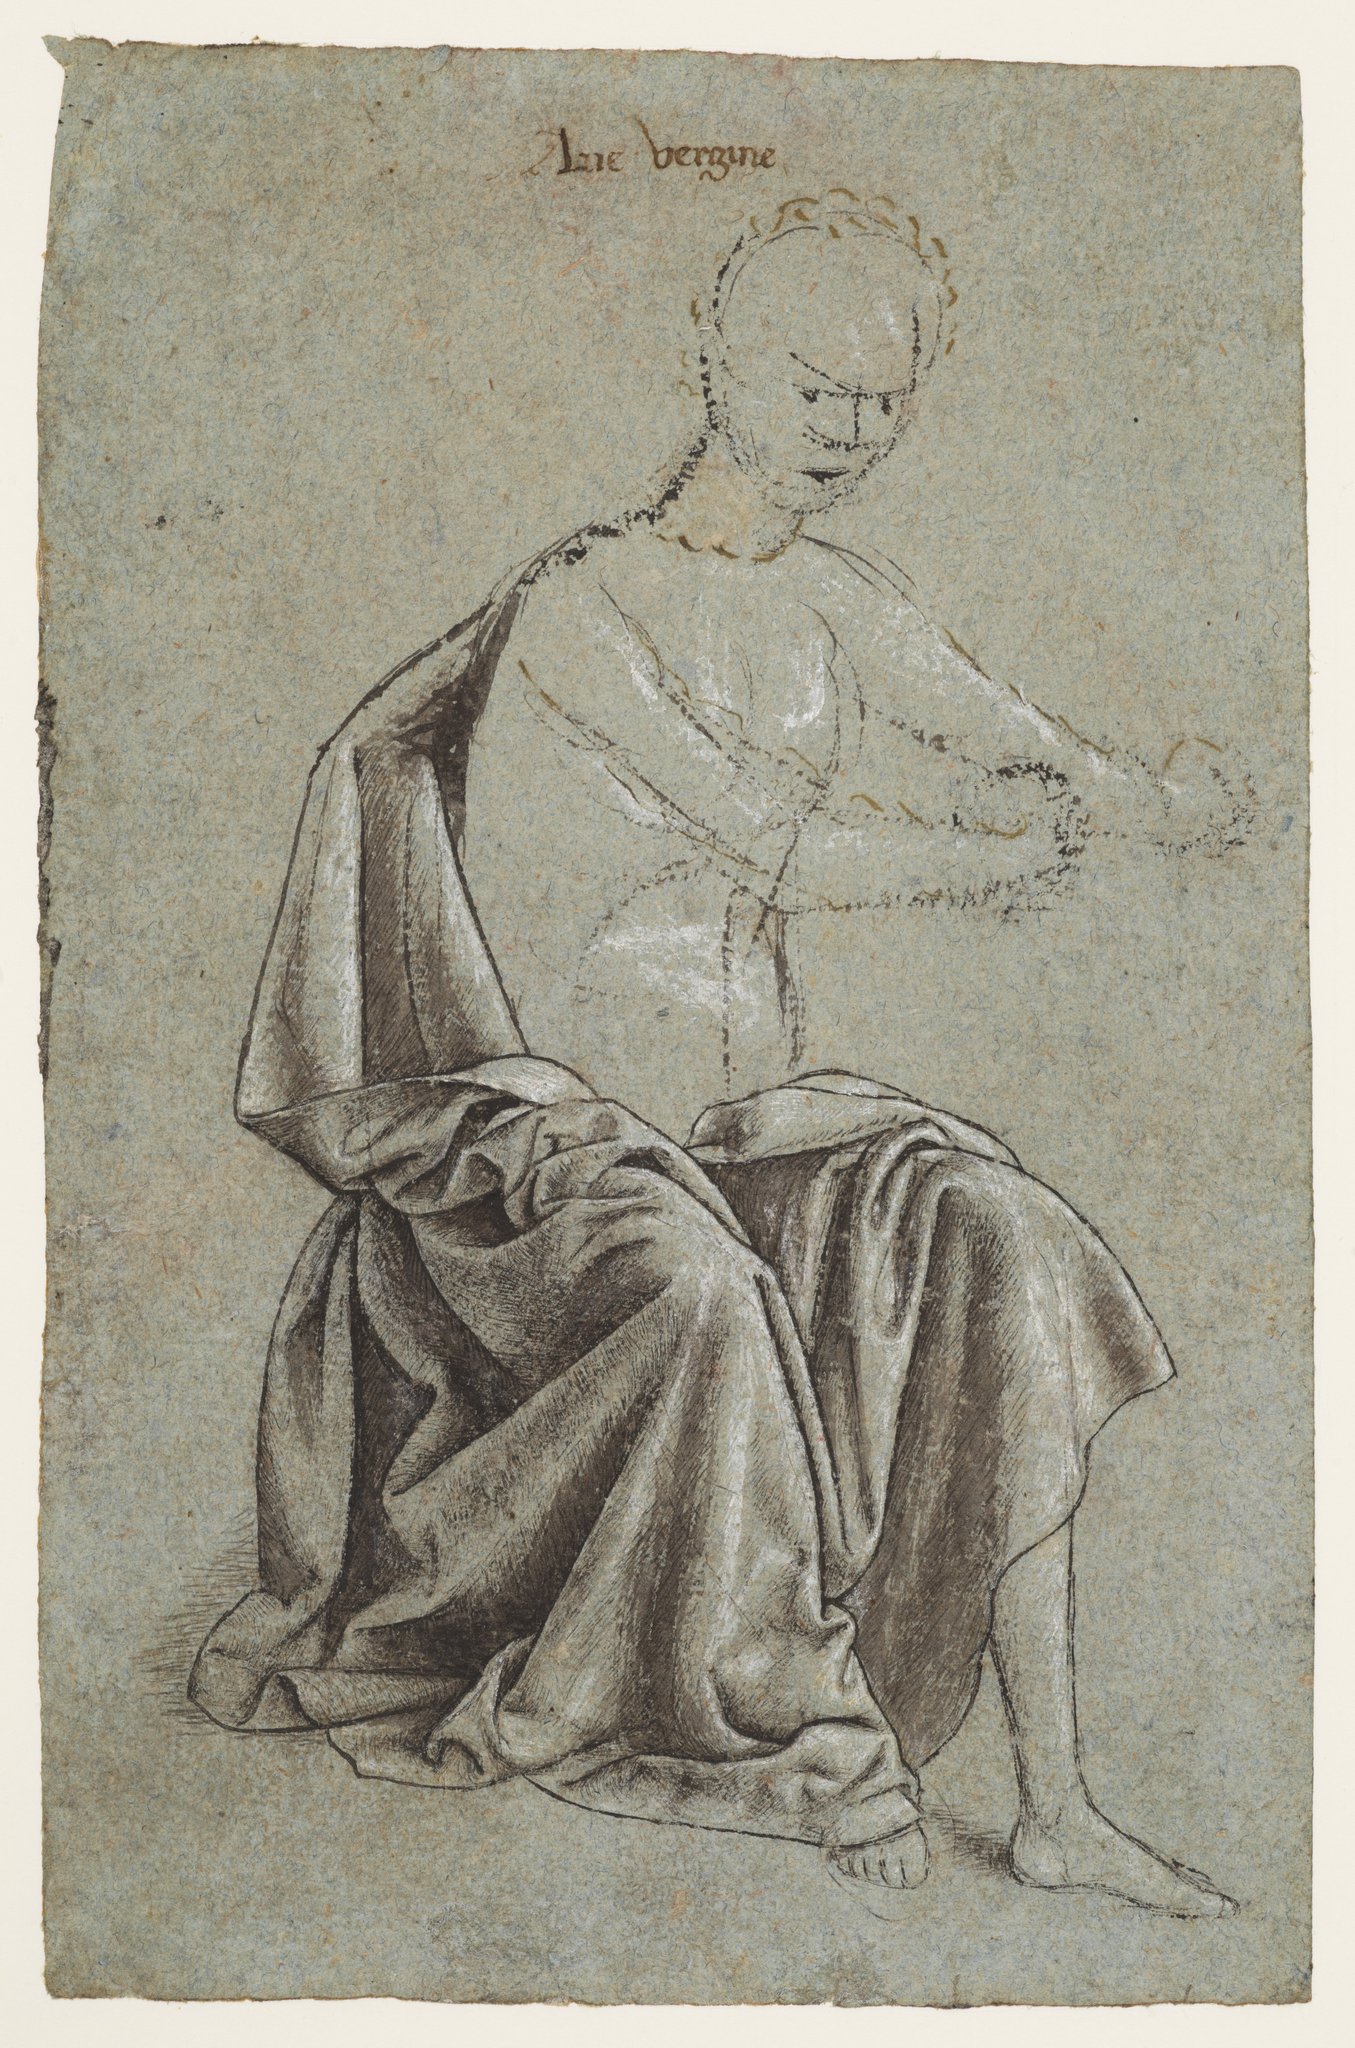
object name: drawing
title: Study of a Seated Mannequin with an Arrangement of Drapery, for a Figure of the Virgin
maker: anonymous, north-italian, probably lombard, 15th century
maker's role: artist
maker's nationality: italian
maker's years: 1470-1500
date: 1401-1500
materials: chalk, gouache, ink, paper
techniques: highlighting, pen, wash